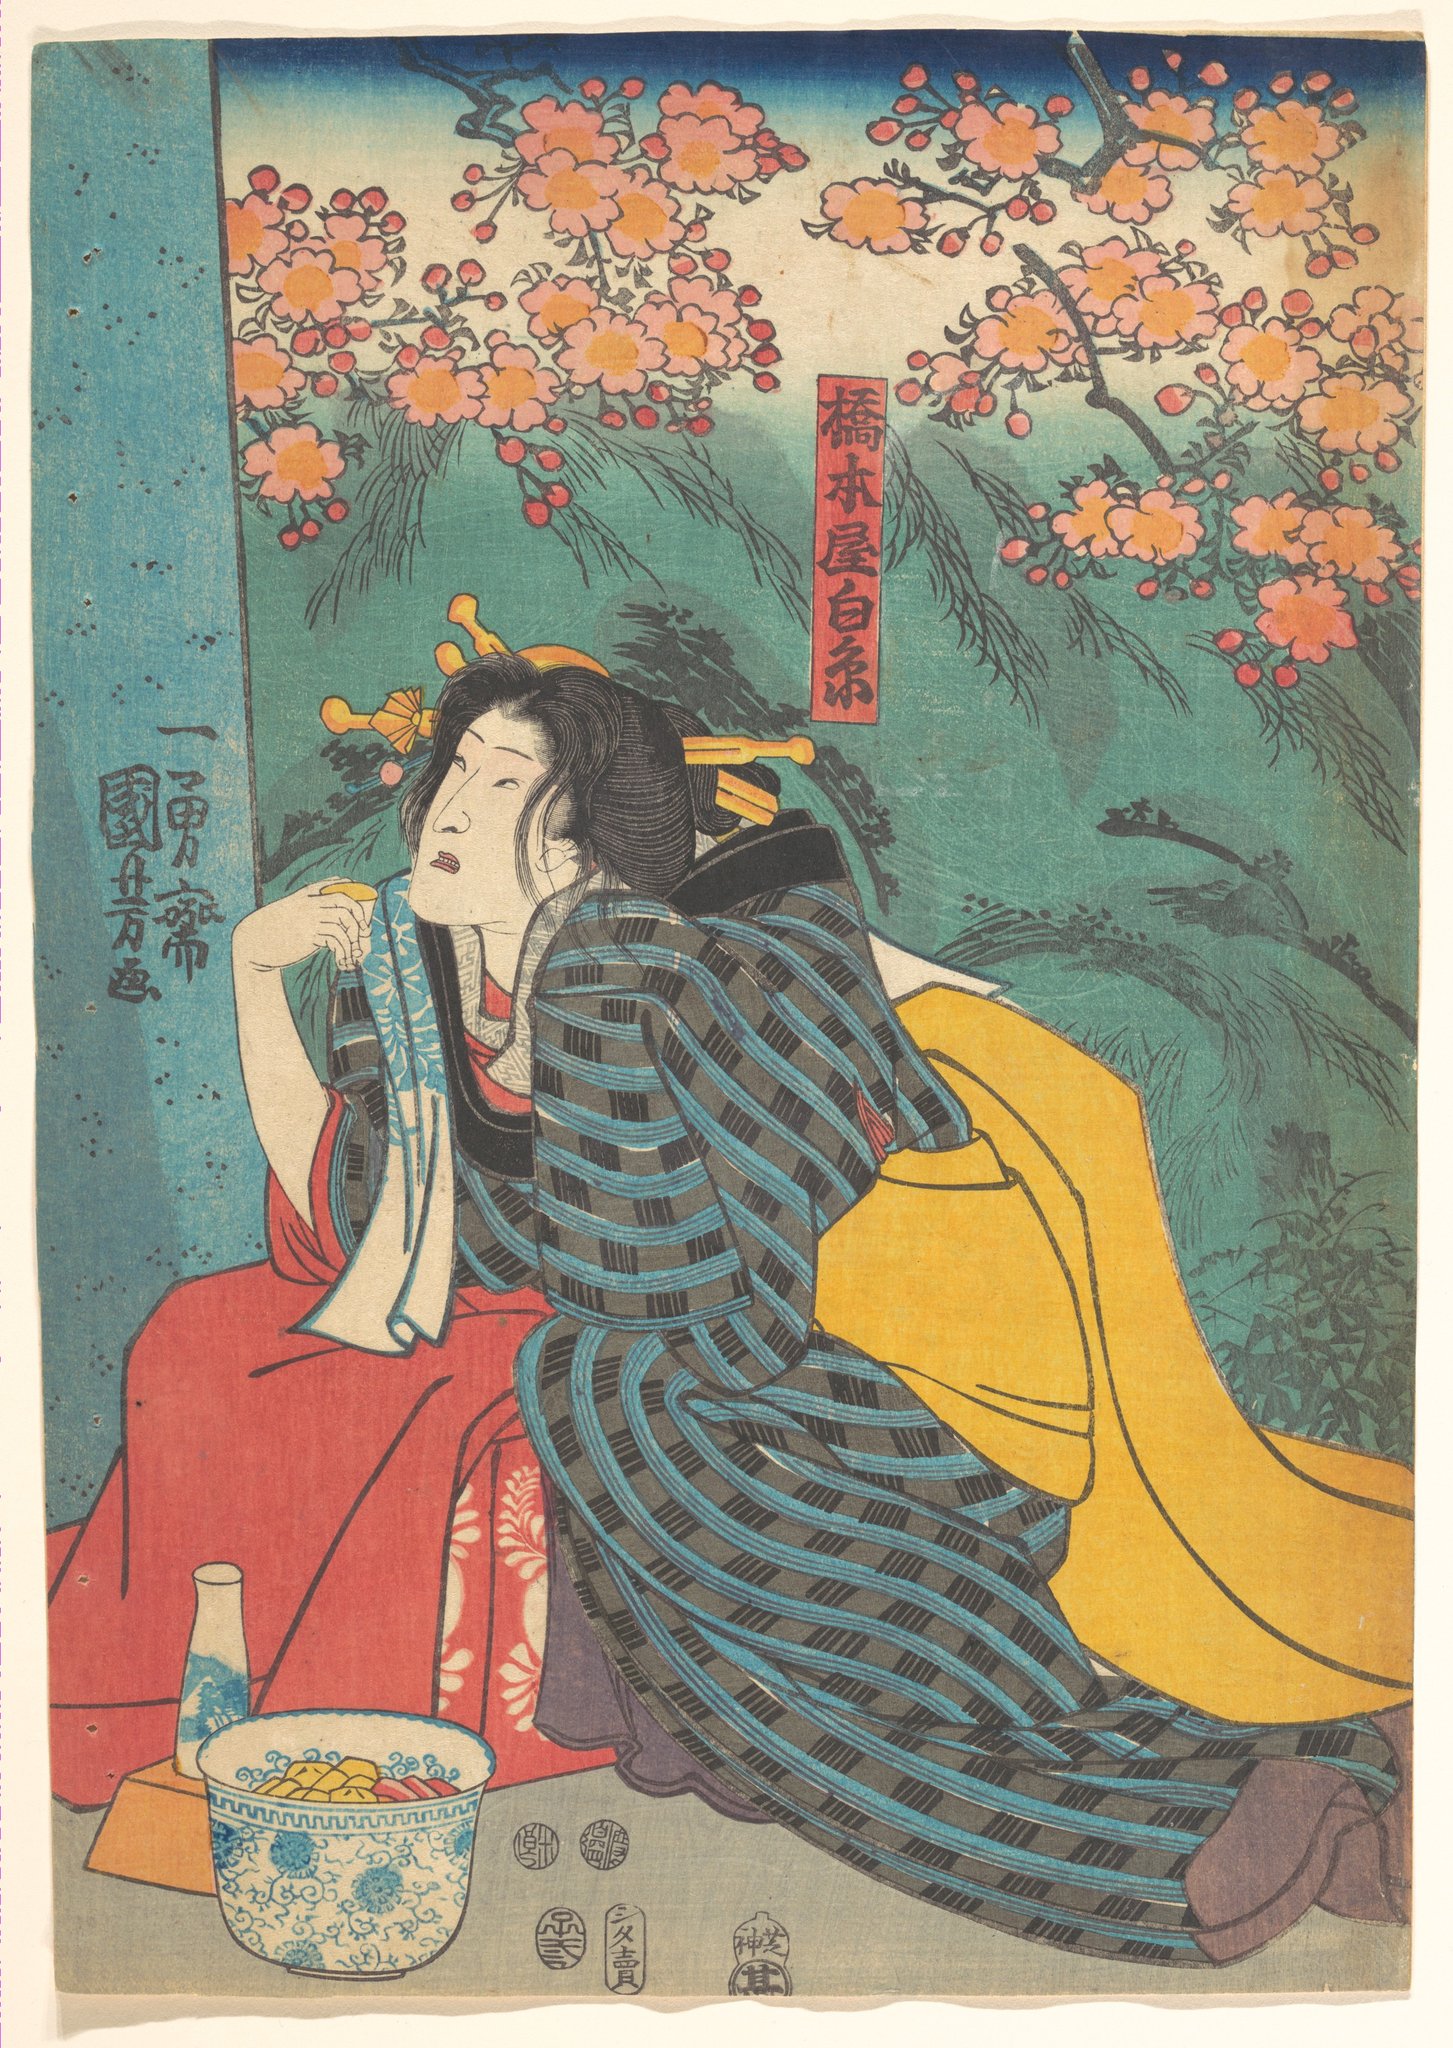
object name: print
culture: japanese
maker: utagawa kuniyoshi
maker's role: artist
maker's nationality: japanese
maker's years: 1797-1861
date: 1801-1900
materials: ink, paper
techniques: woodblock print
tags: women